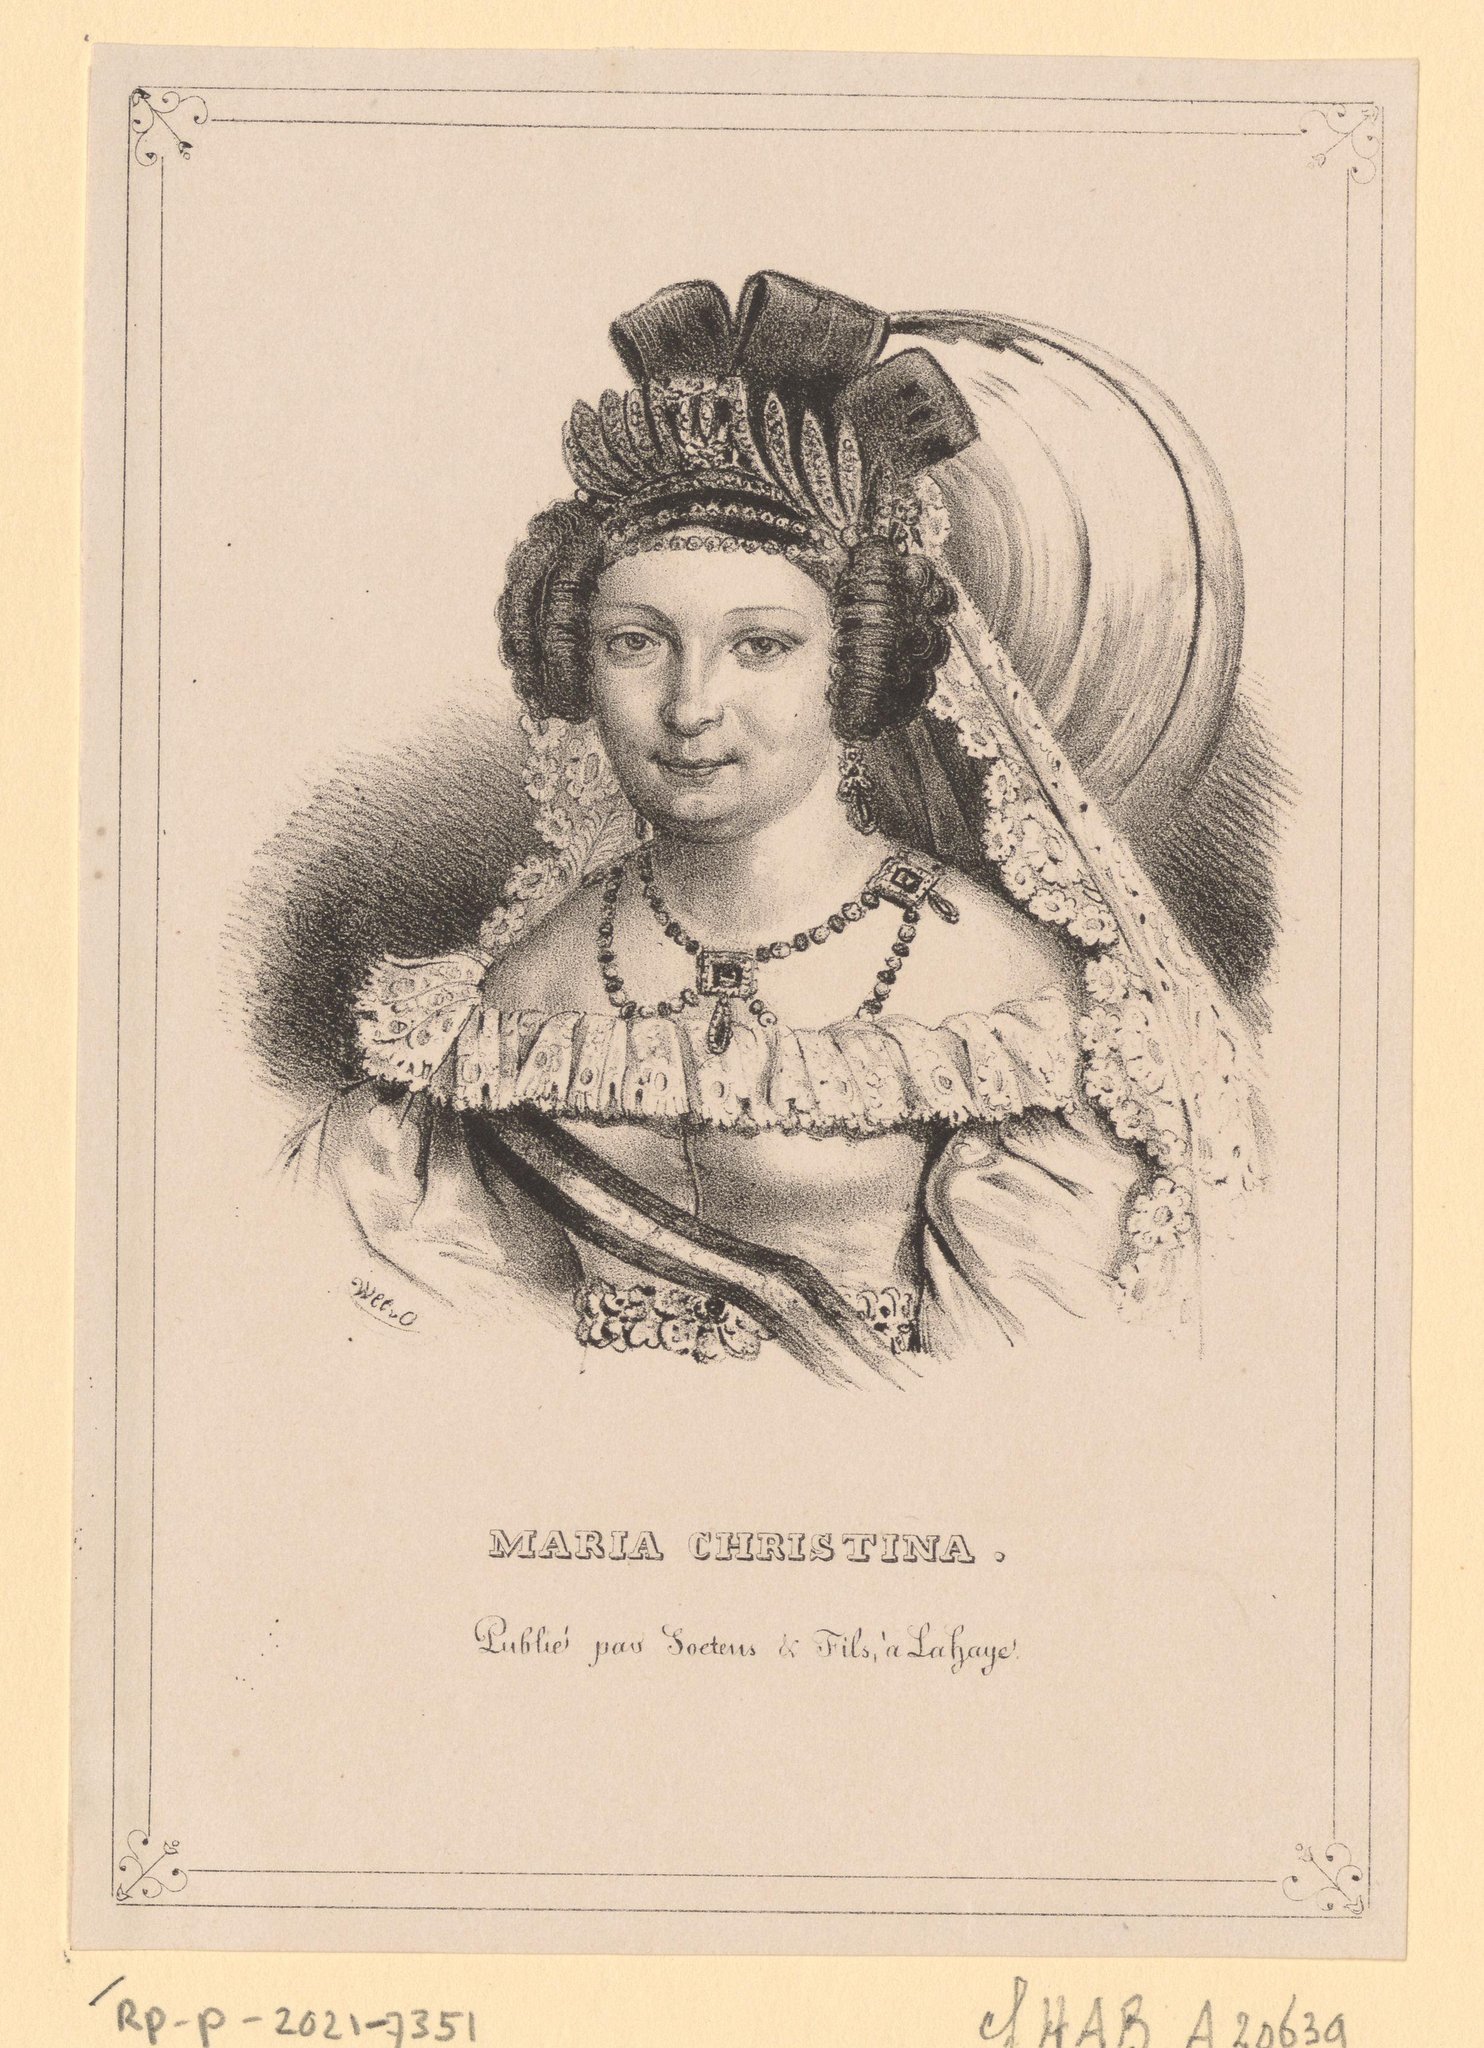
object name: print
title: Portret van Maria Christina van Oostenrijk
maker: wilhelmus cornelis chimaer van oudendorp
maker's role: print maker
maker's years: 1822-1873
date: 1837-1840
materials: paper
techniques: lithograph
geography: netherlands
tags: vienna, maria christina van oostenrijk (1742-1798), historical persons - bb - woman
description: Deze prent maakte waarschijnlijk deel uit van een serie uitgegeven door Soetens et Fils omstreeks 1838, opgedragen aan de Prins van Oranje. In de 'Prospectus en Inteekenlijst' stond vermeld dat het zal bestaan uit een onbepaald aantal portretten, waarvan er drie of vier per maand verschijnen. Zie Van Someren.